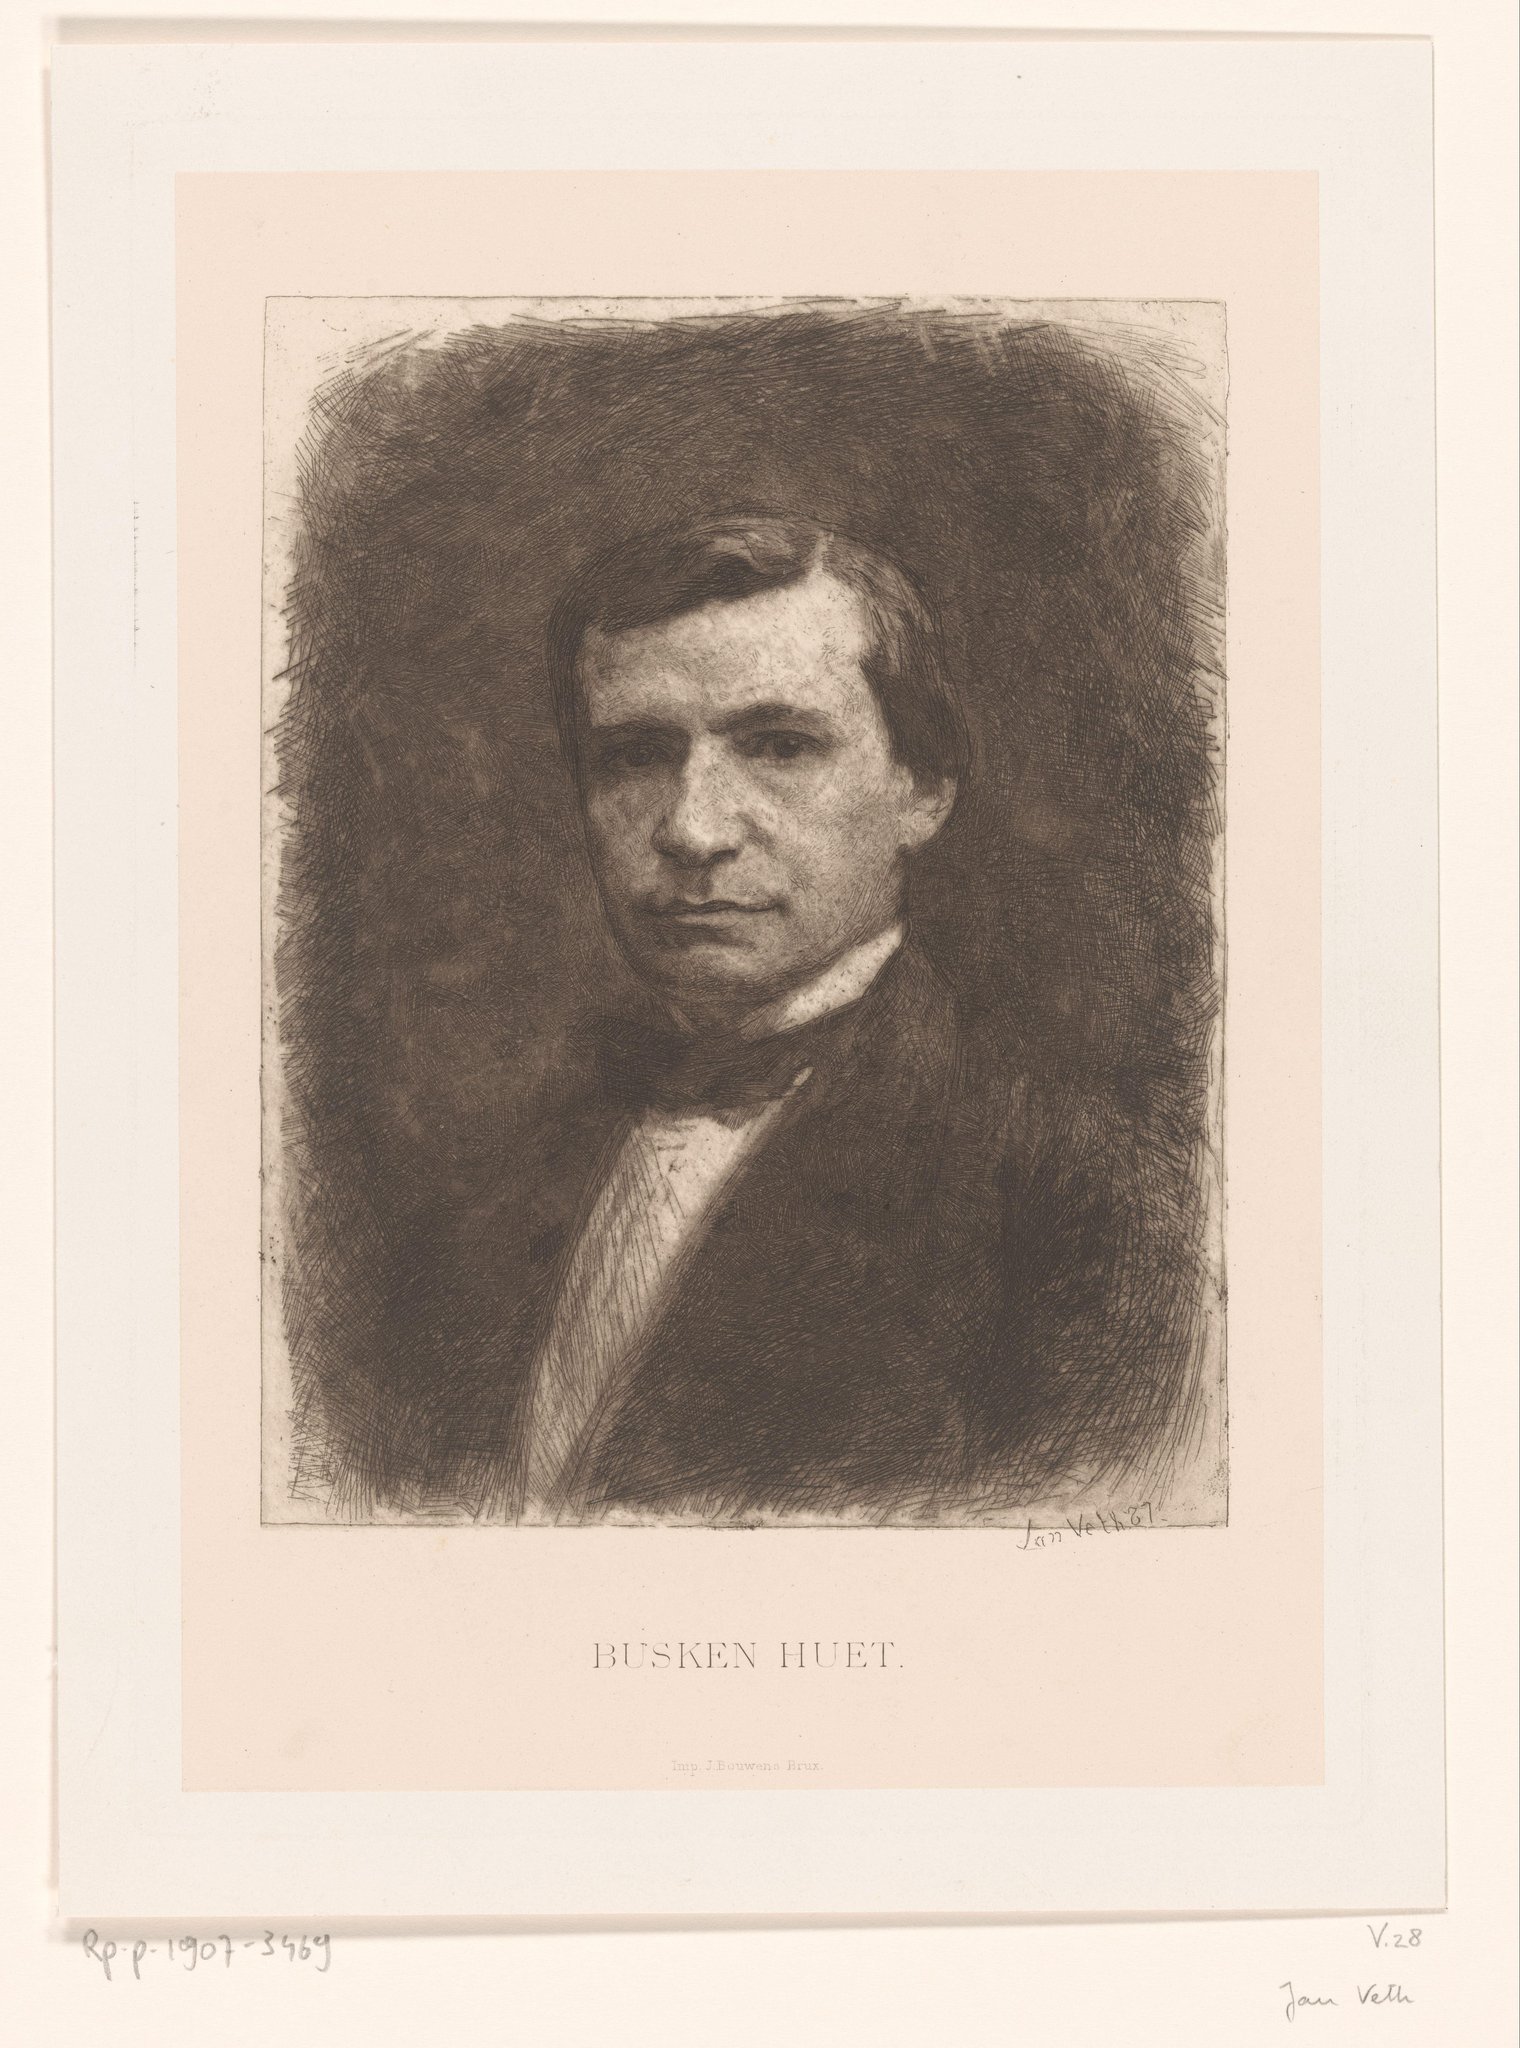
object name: print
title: Busken Huet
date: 1887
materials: paper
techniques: etching, intaglio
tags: historical persons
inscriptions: collector's mark: Lugt 2228